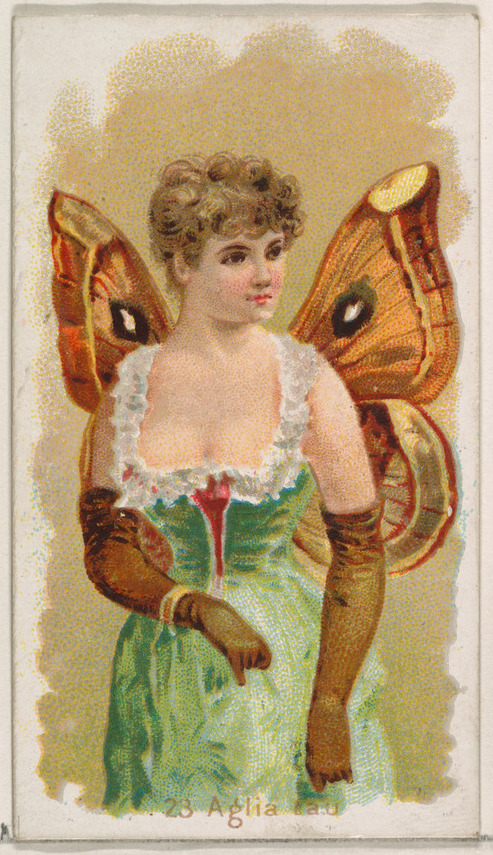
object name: print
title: Card 23, Aglia Tau, from the Butterflies series (N183) issued by Wm. S. Kimball & Co.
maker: william s. kimball & company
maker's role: publisher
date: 1888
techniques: color lithograph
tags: women,butterflies